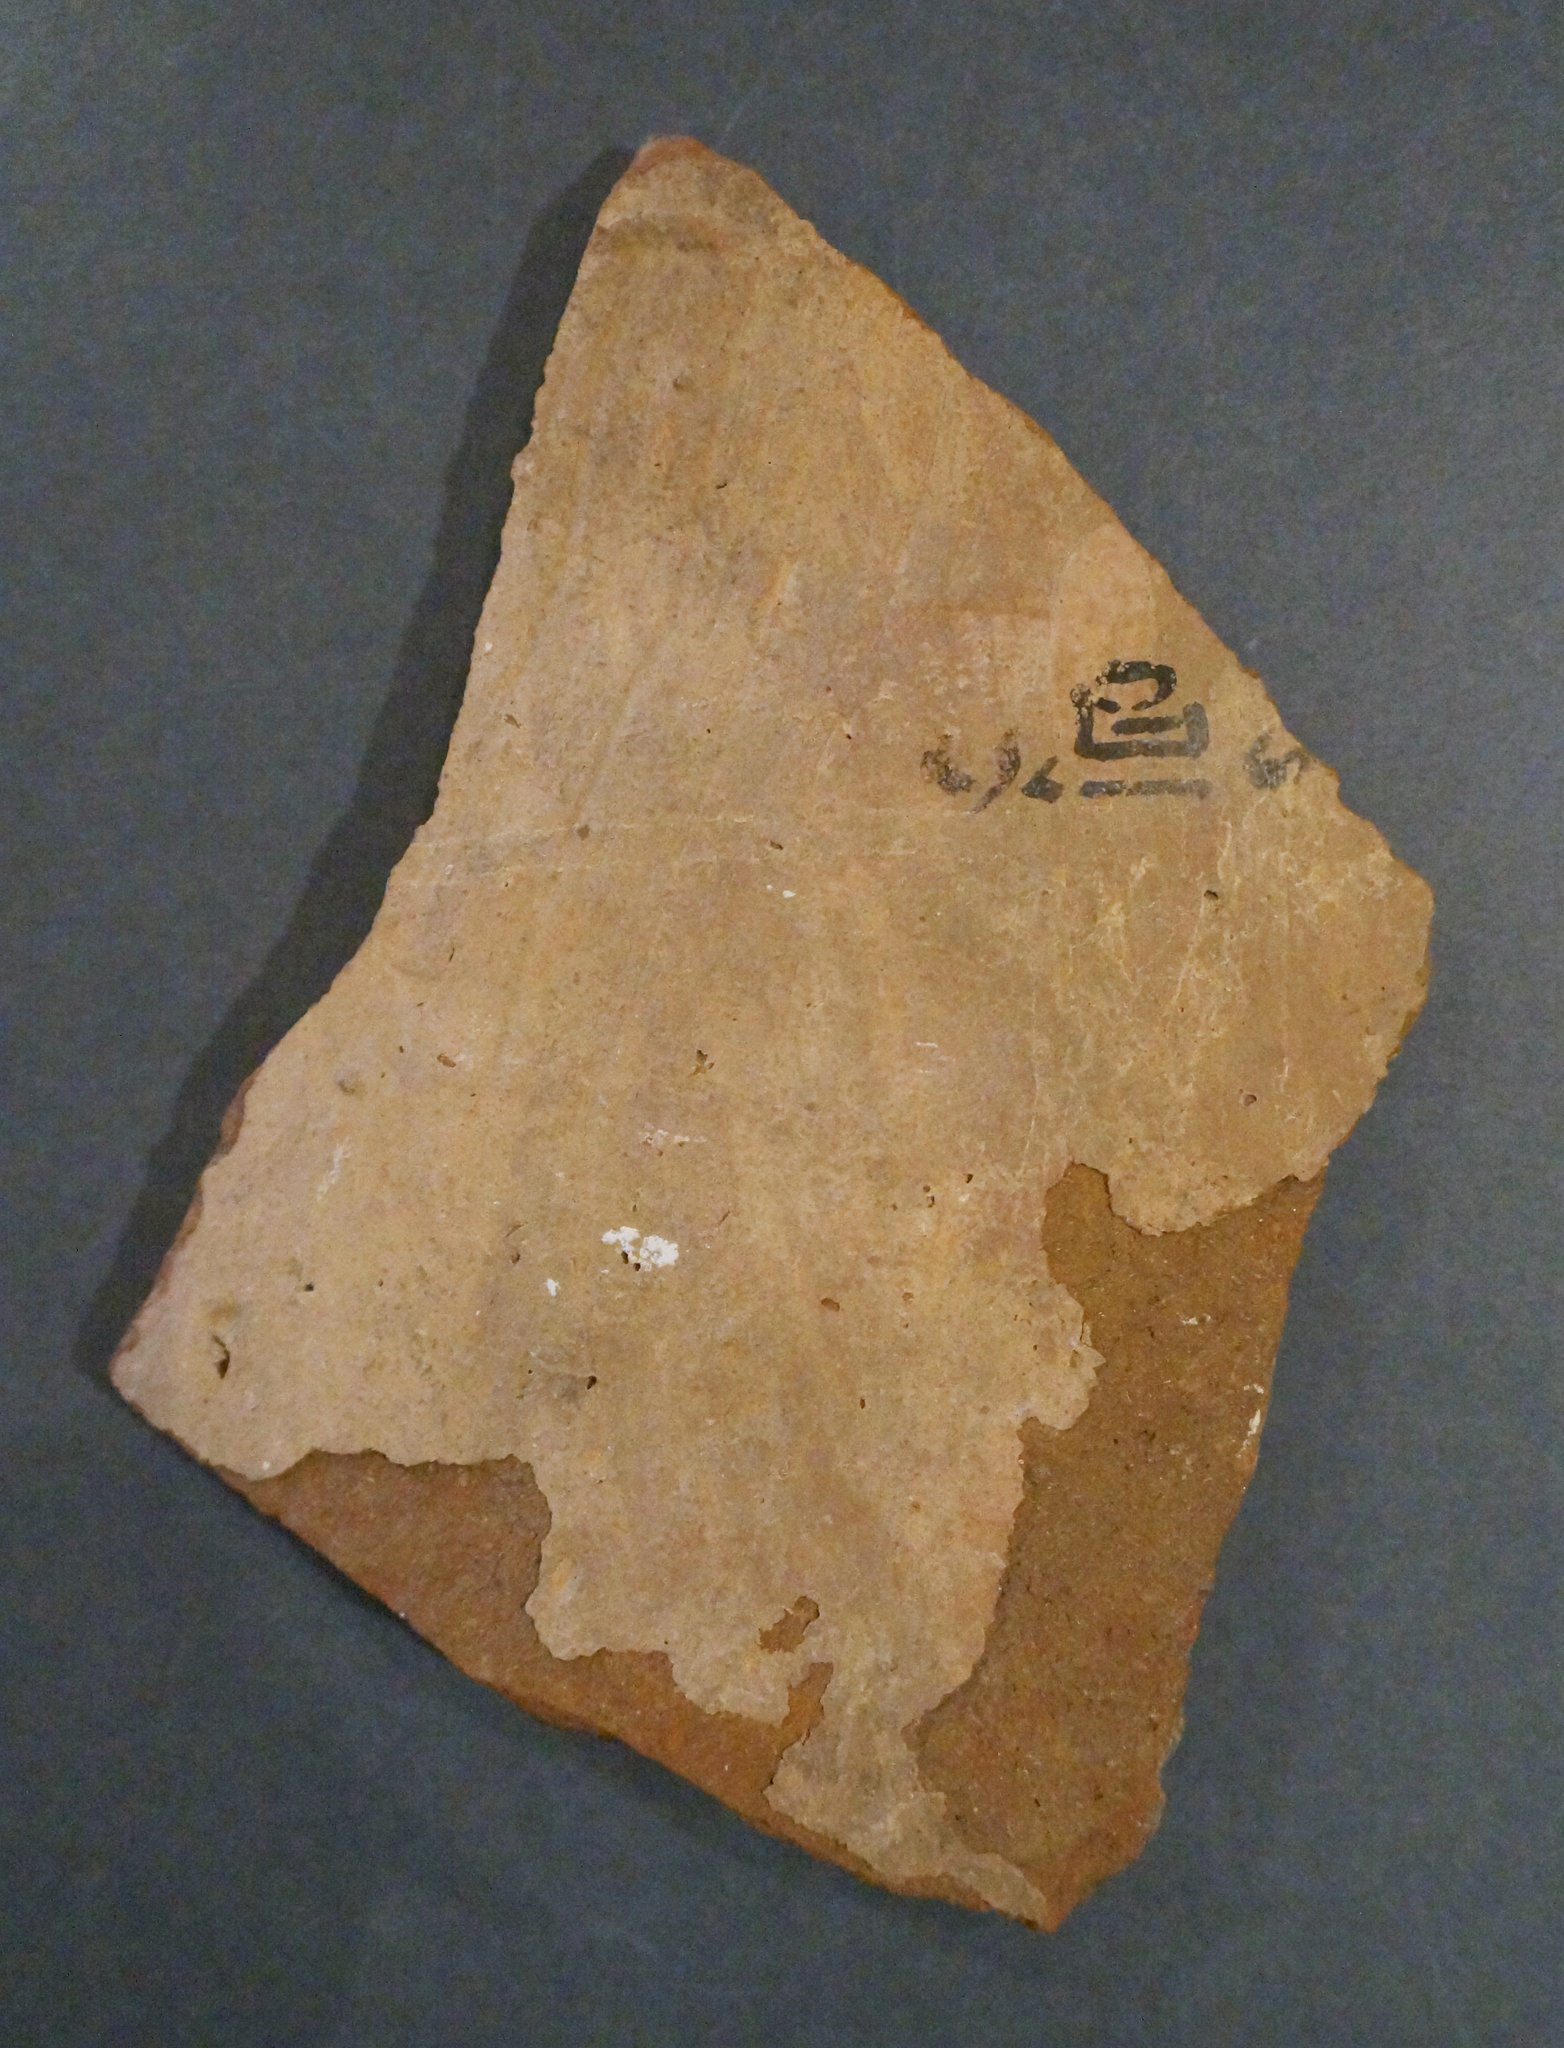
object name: jar label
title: Inscribed Pot Fragment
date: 1580-1479 BCE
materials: ink, pottery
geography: egypt